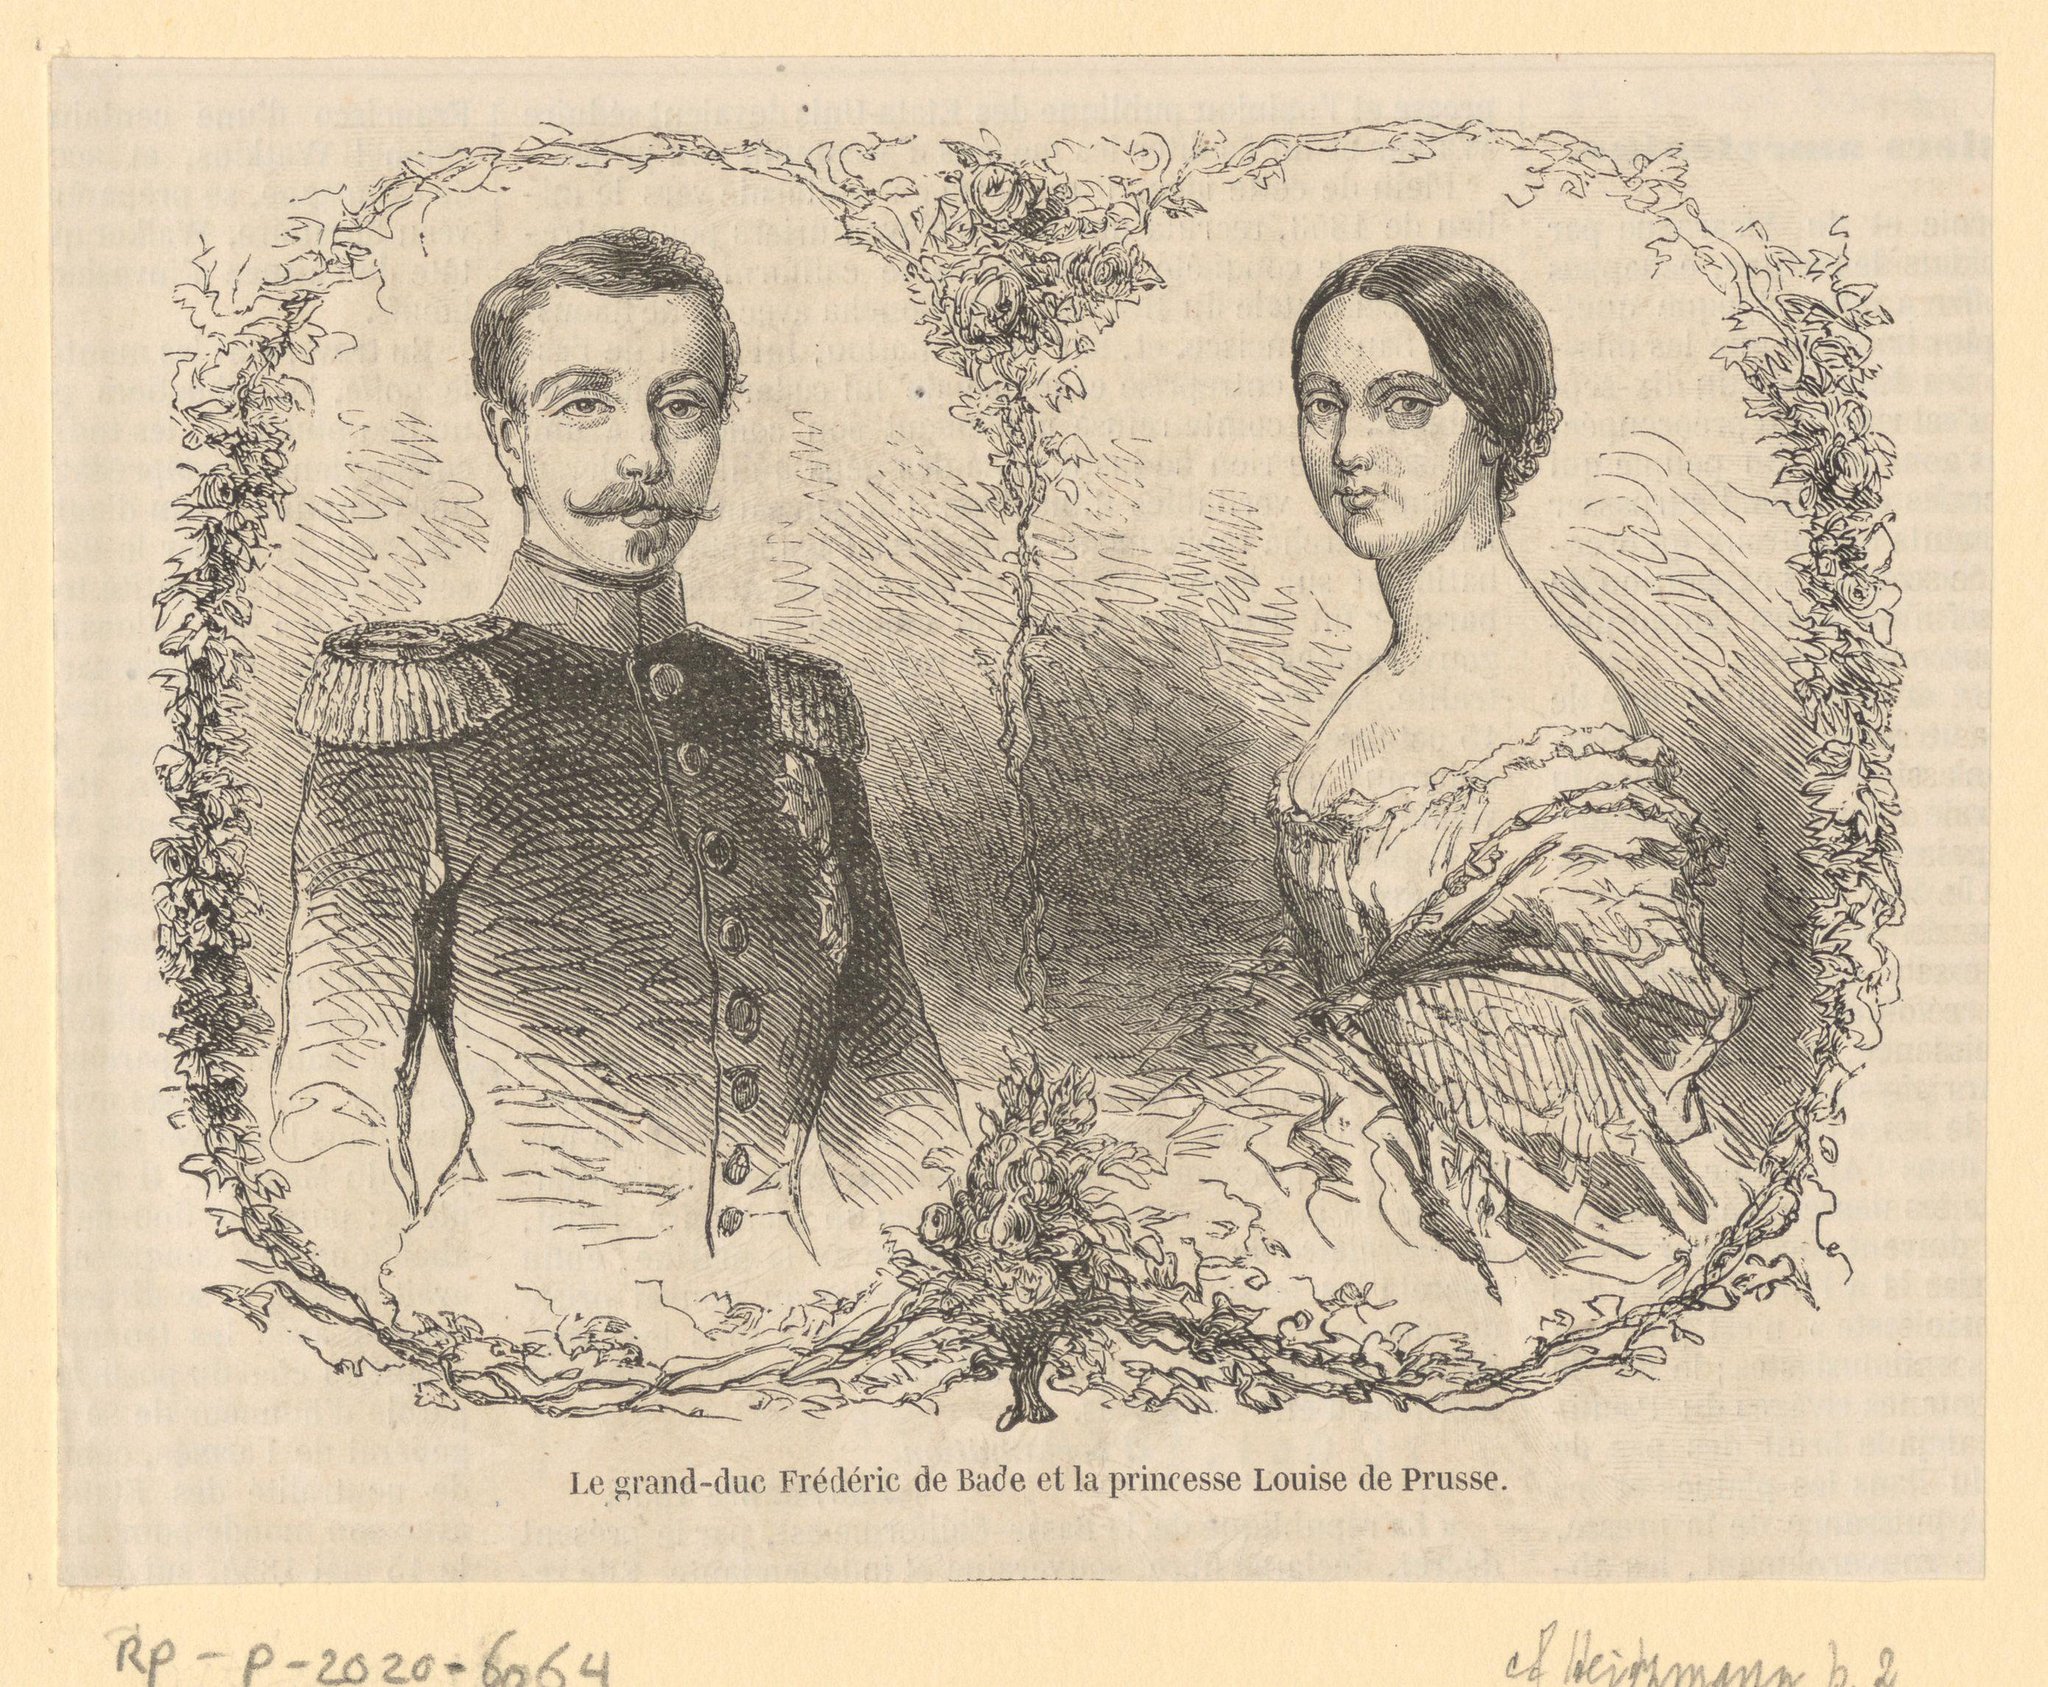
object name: print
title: Portret van Frederik I van Baden en Louise Marie Elisabeth van Pruisen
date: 1856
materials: paper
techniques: letterpress printing, engraving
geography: paris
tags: historical person in a double portrait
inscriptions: stamp: ‘L'Illustration/ 11 Oct. 1856’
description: Prent uit: L'Illustration 28 (1856), nr. 711, 11 oktober 1856, p. 229.